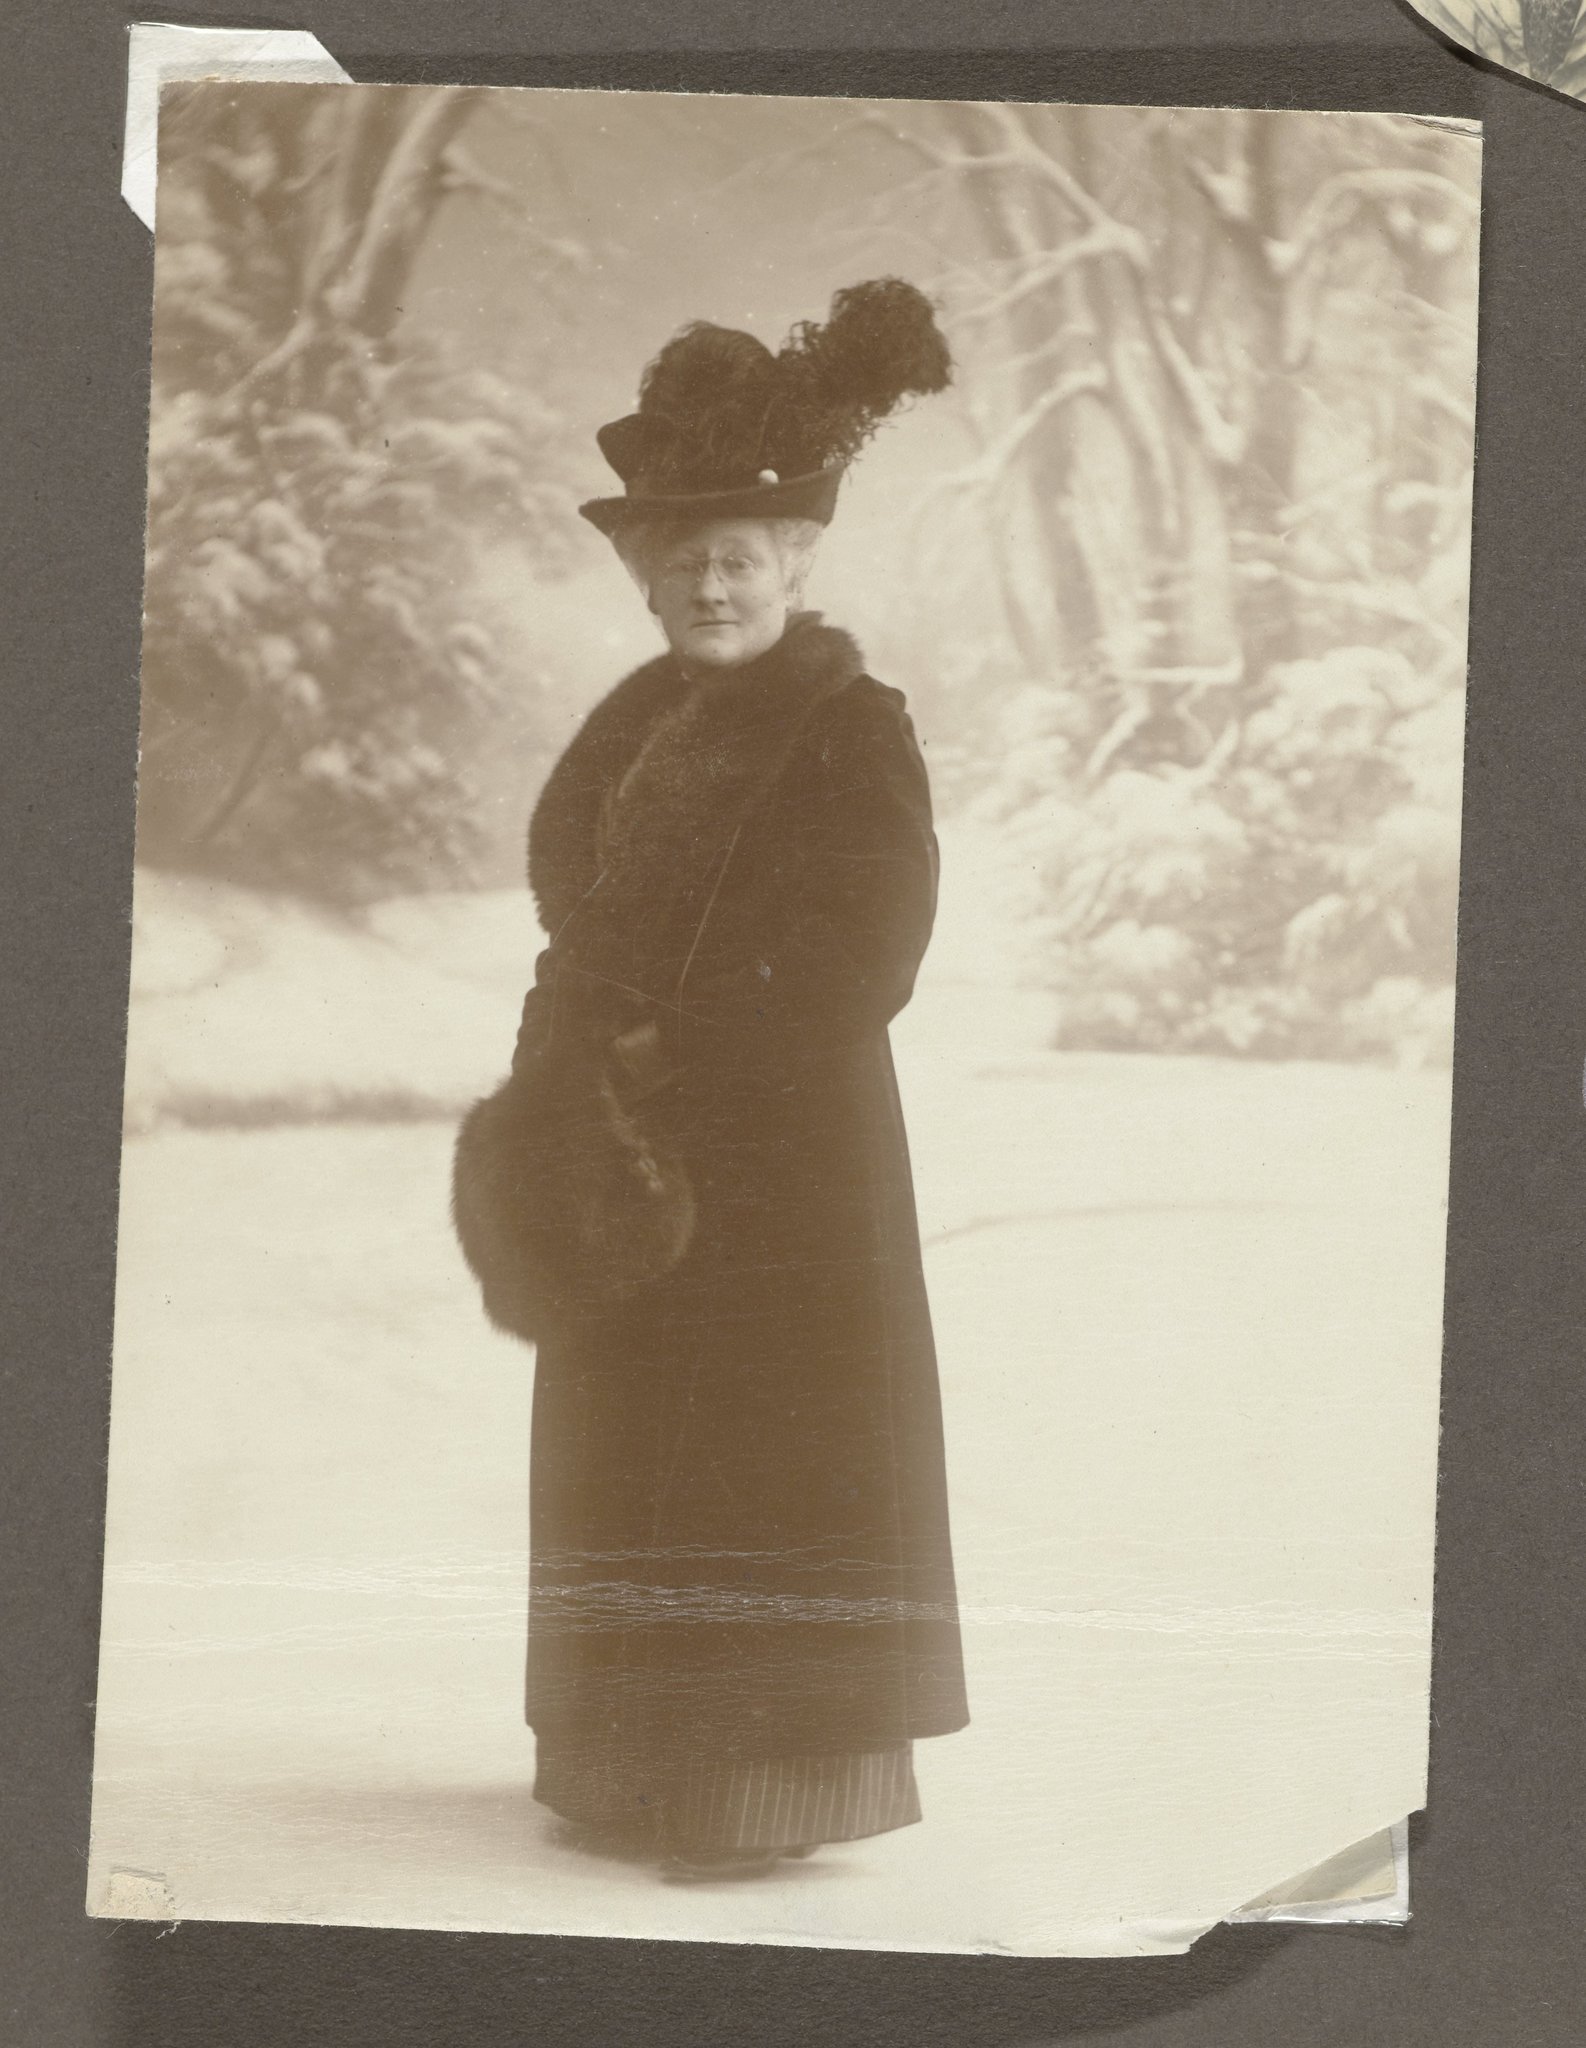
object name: photograph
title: Portret van Grietje Vermeulen-Luitjes in winterkleding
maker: cornelis johannes lodewicus vermeulen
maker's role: fotograaf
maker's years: 1861-1936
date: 1900-1925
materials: paper, cardboard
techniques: gelatin silver print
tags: historical persons - bb - woman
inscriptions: inscription: ‘oma’